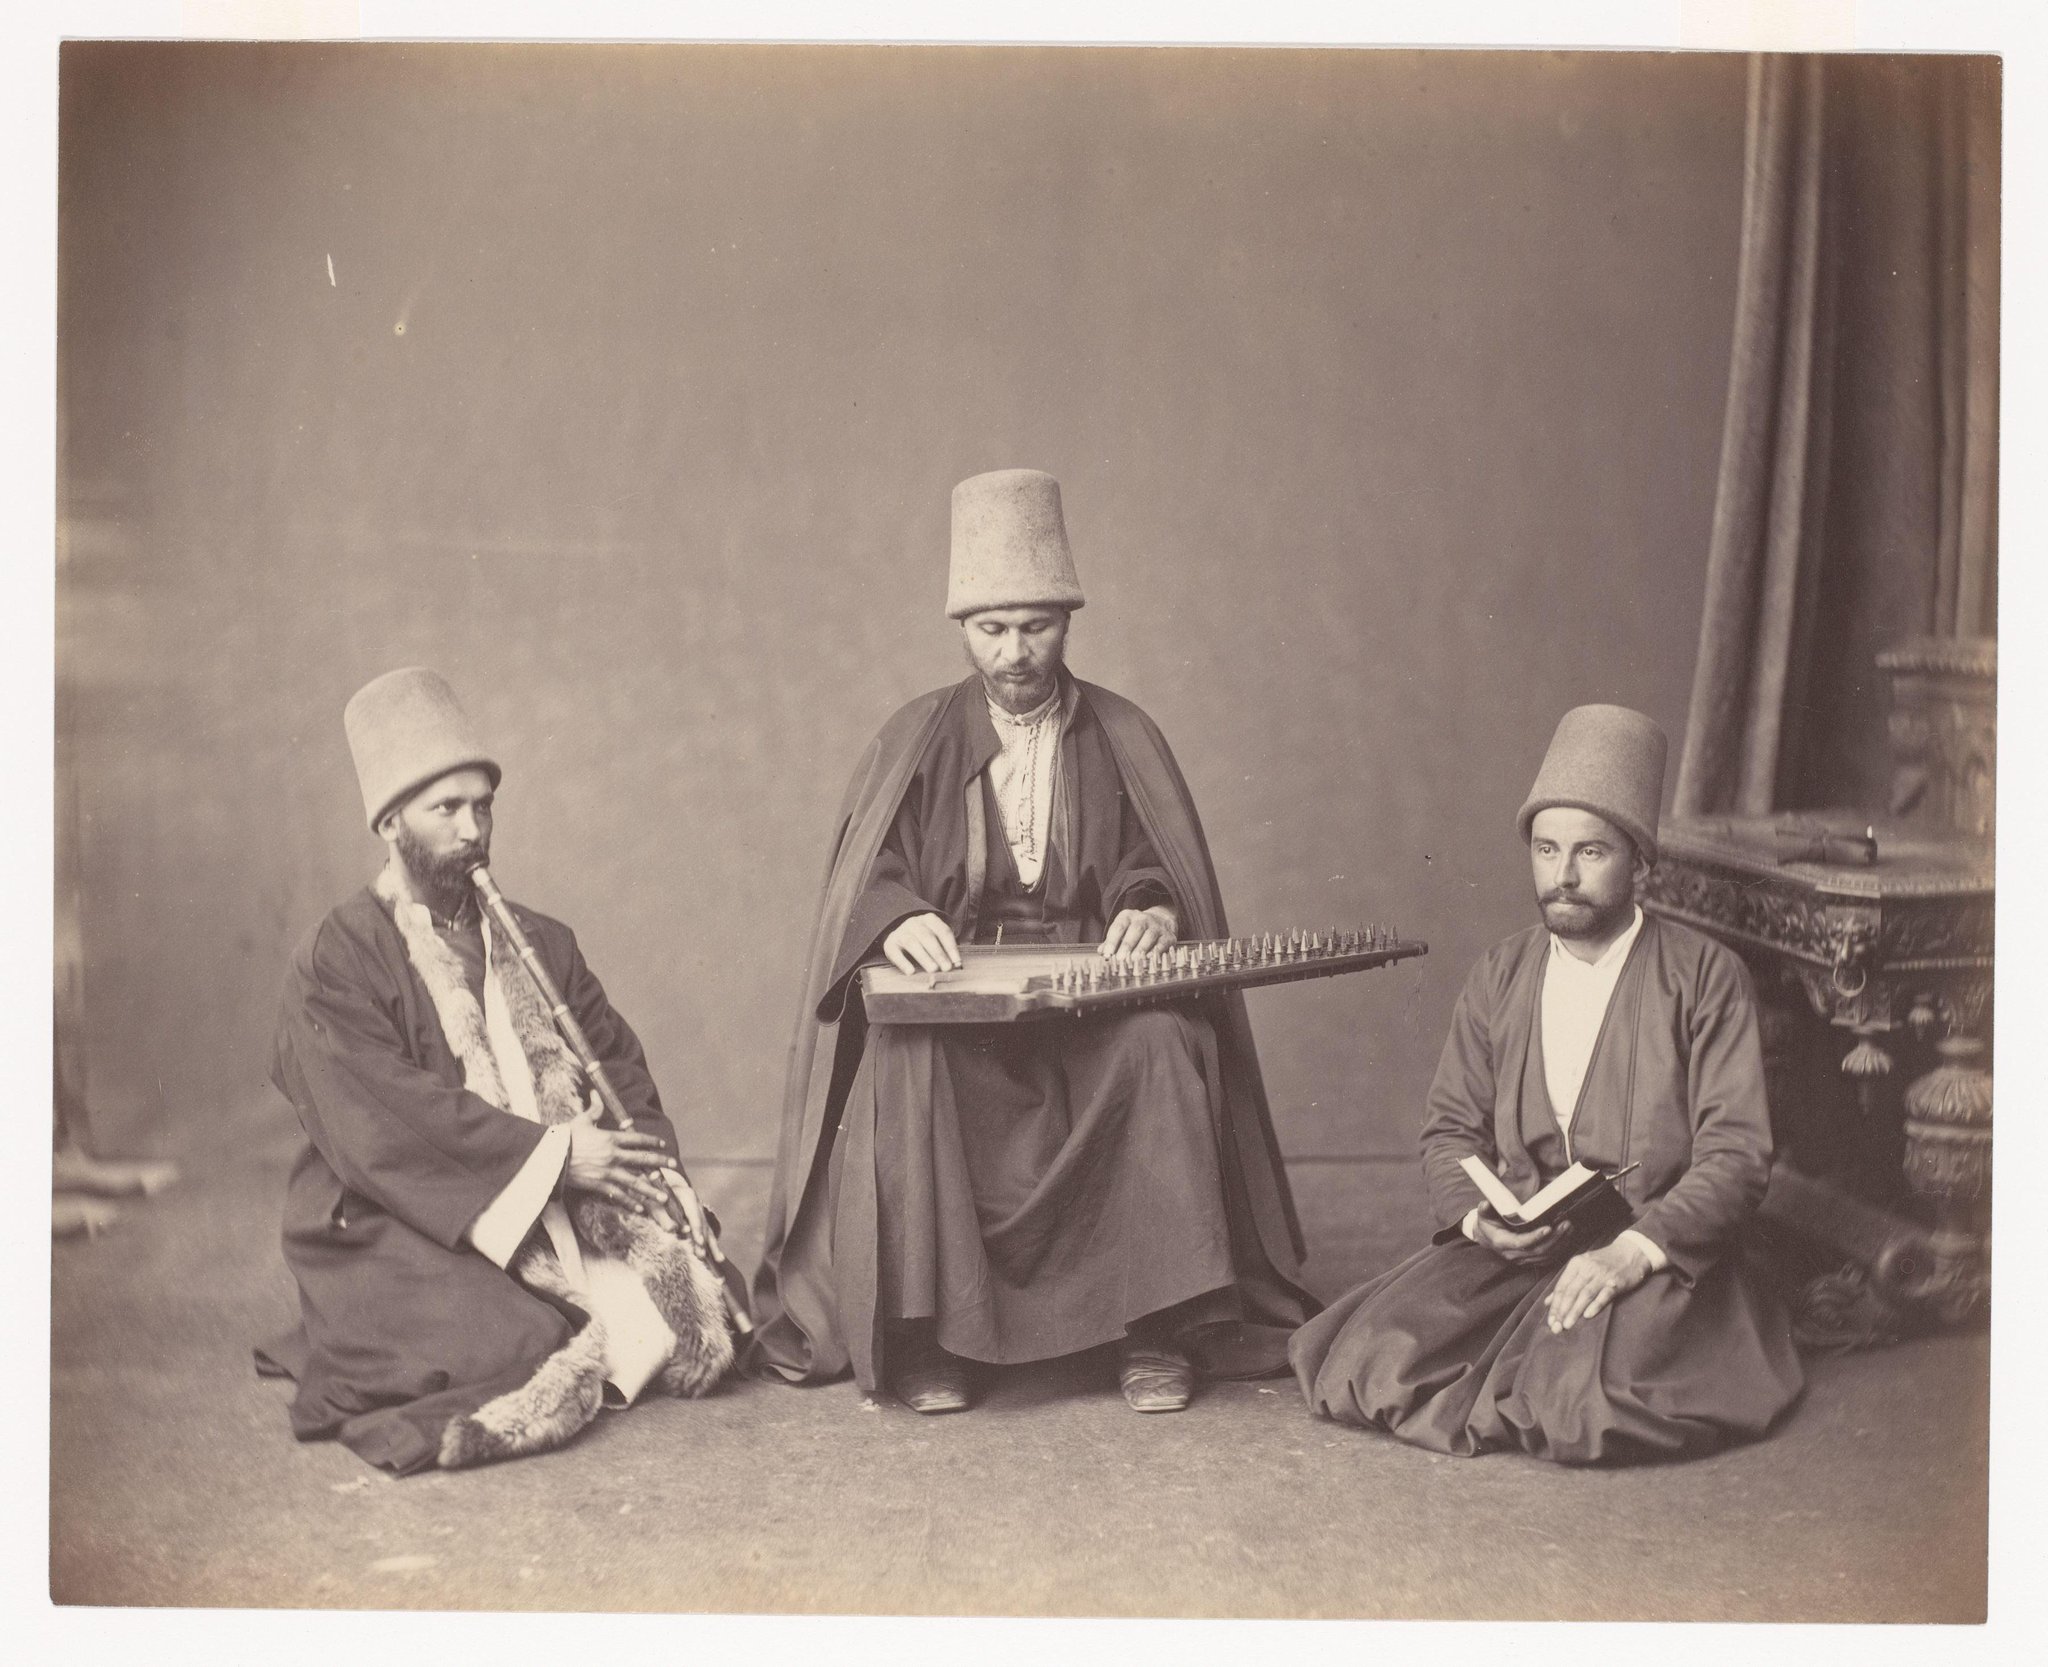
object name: photograph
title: Derwisjen met instrumenten, Constantinopel (huidige Istanboel), Ottomaanse Rijk (huidige Turkije)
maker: Anonymous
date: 1870-1900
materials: cardboard, paper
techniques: albumen print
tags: istanboel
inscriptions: number: ‘49’, inscription: ‘Constantinopel’